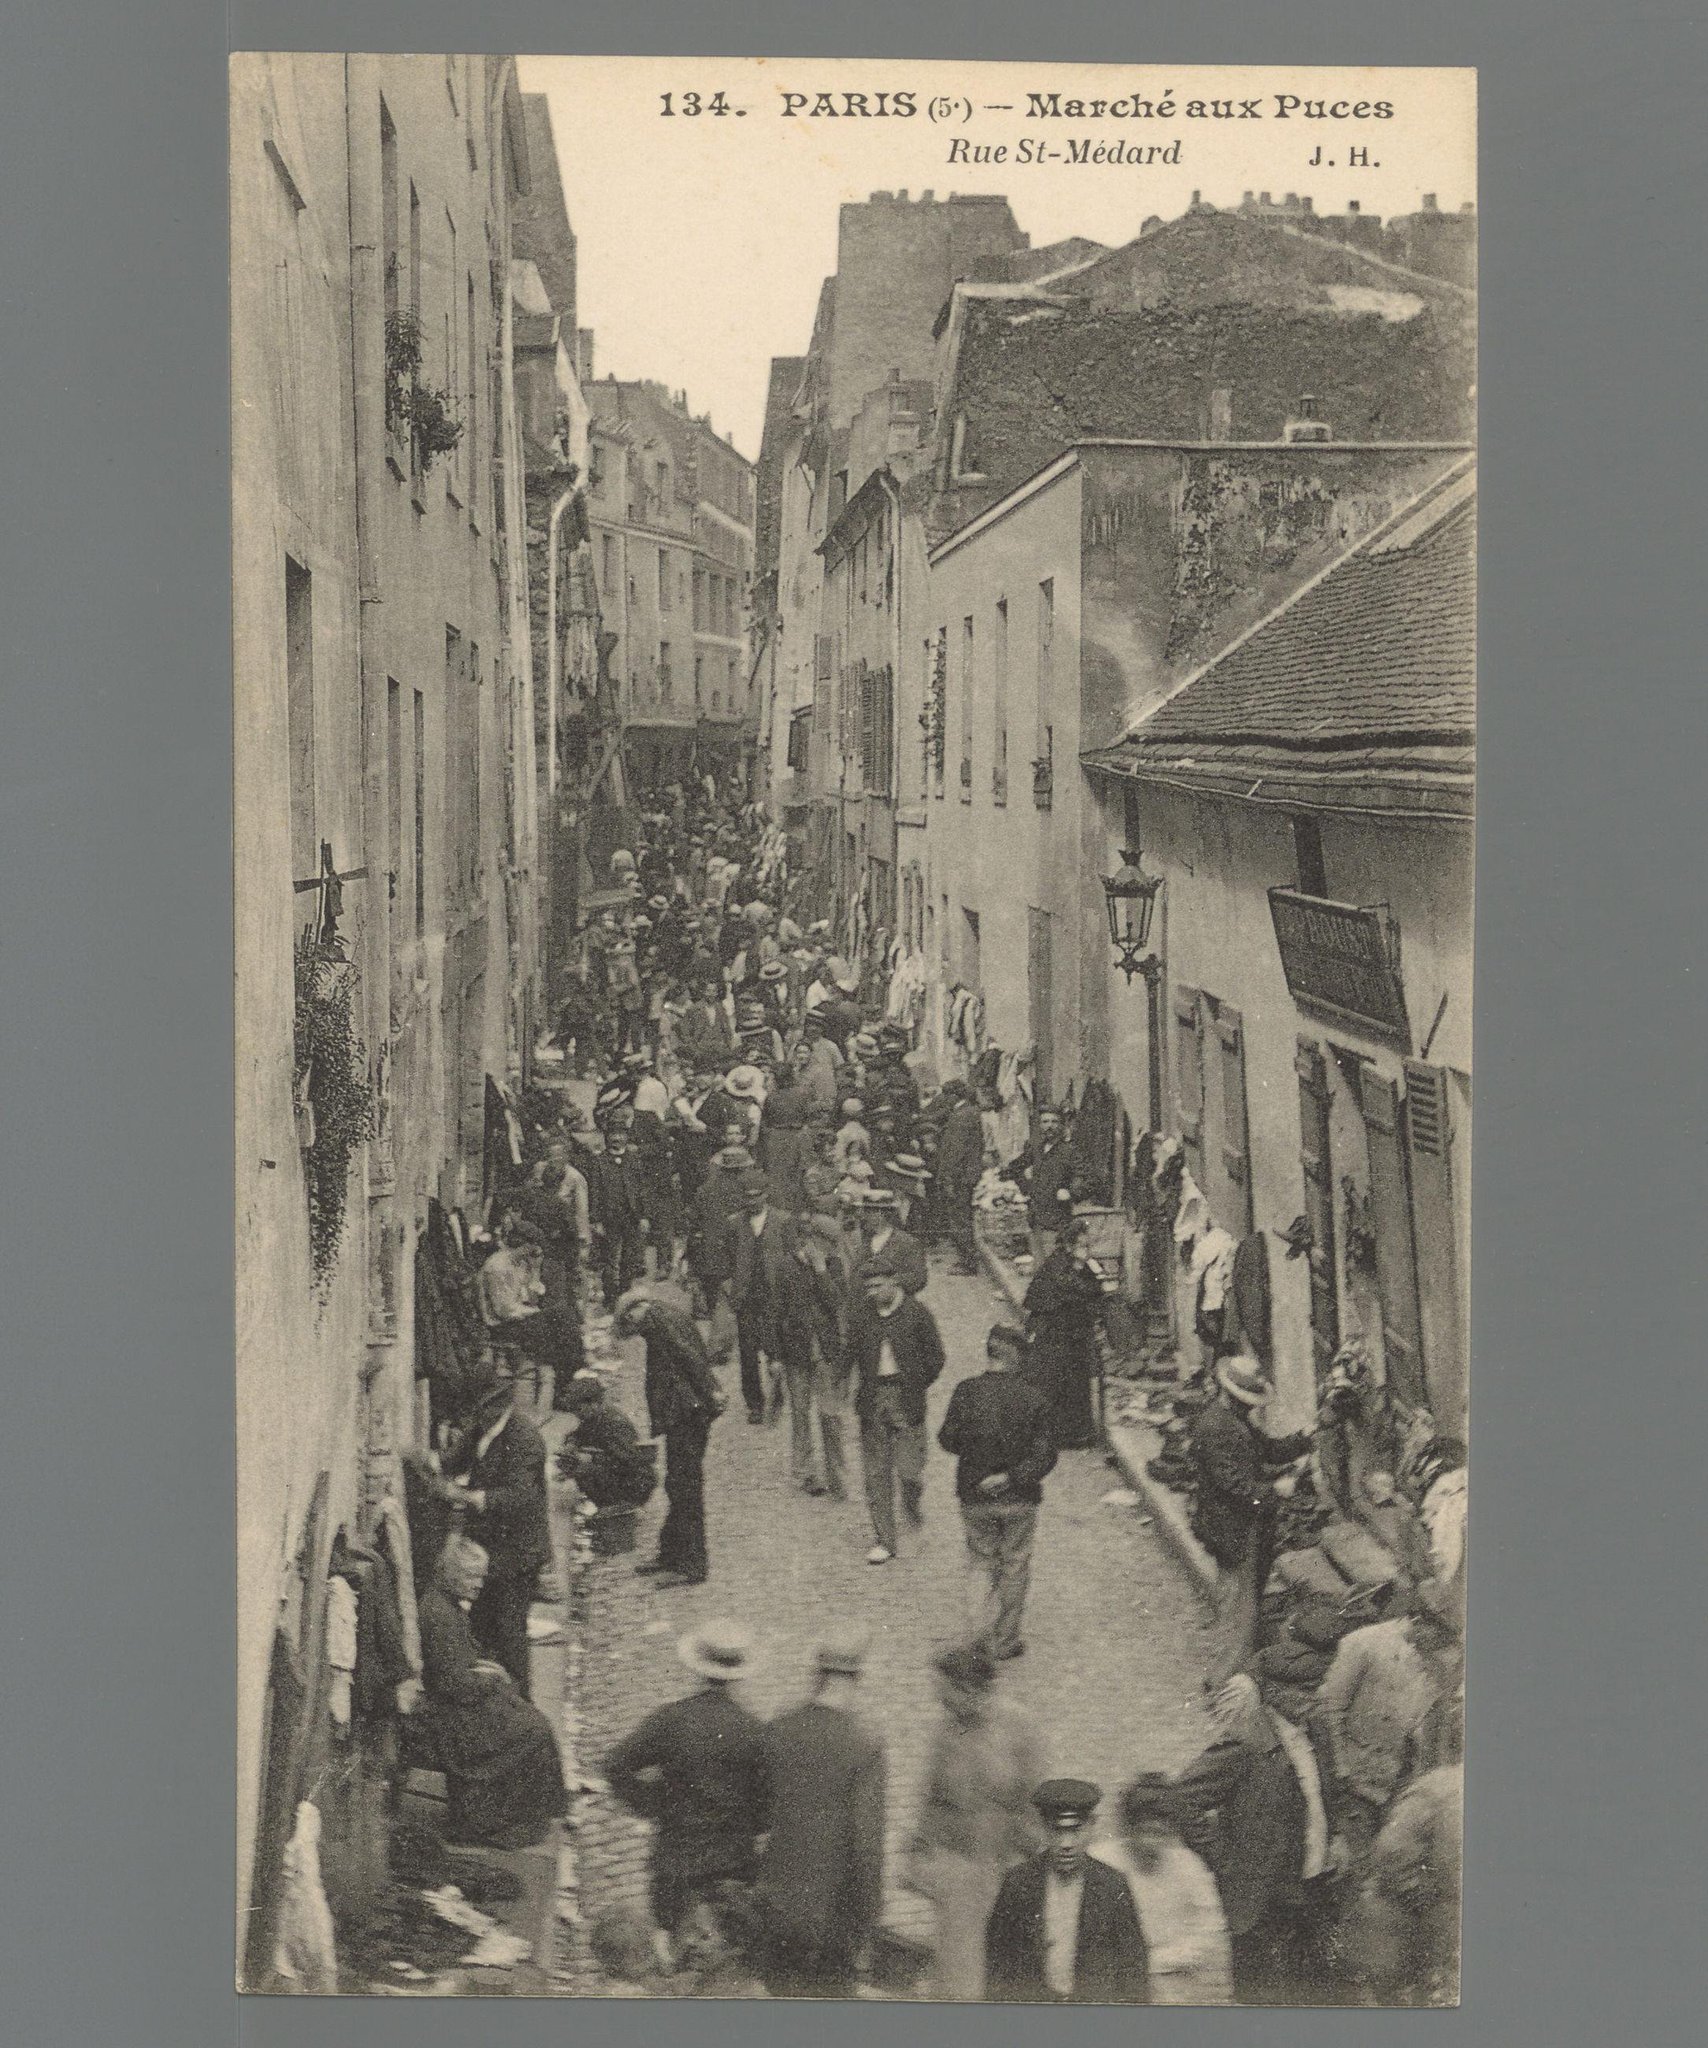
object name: ansichtkaart, prentbriefkaart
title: Paris (5e). Marché aux Puces. Rue St-Médard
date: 1904-1906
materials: cardboard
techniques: photograph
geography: paris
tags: market, street (+ city(-scape) with figures, staffage), paris